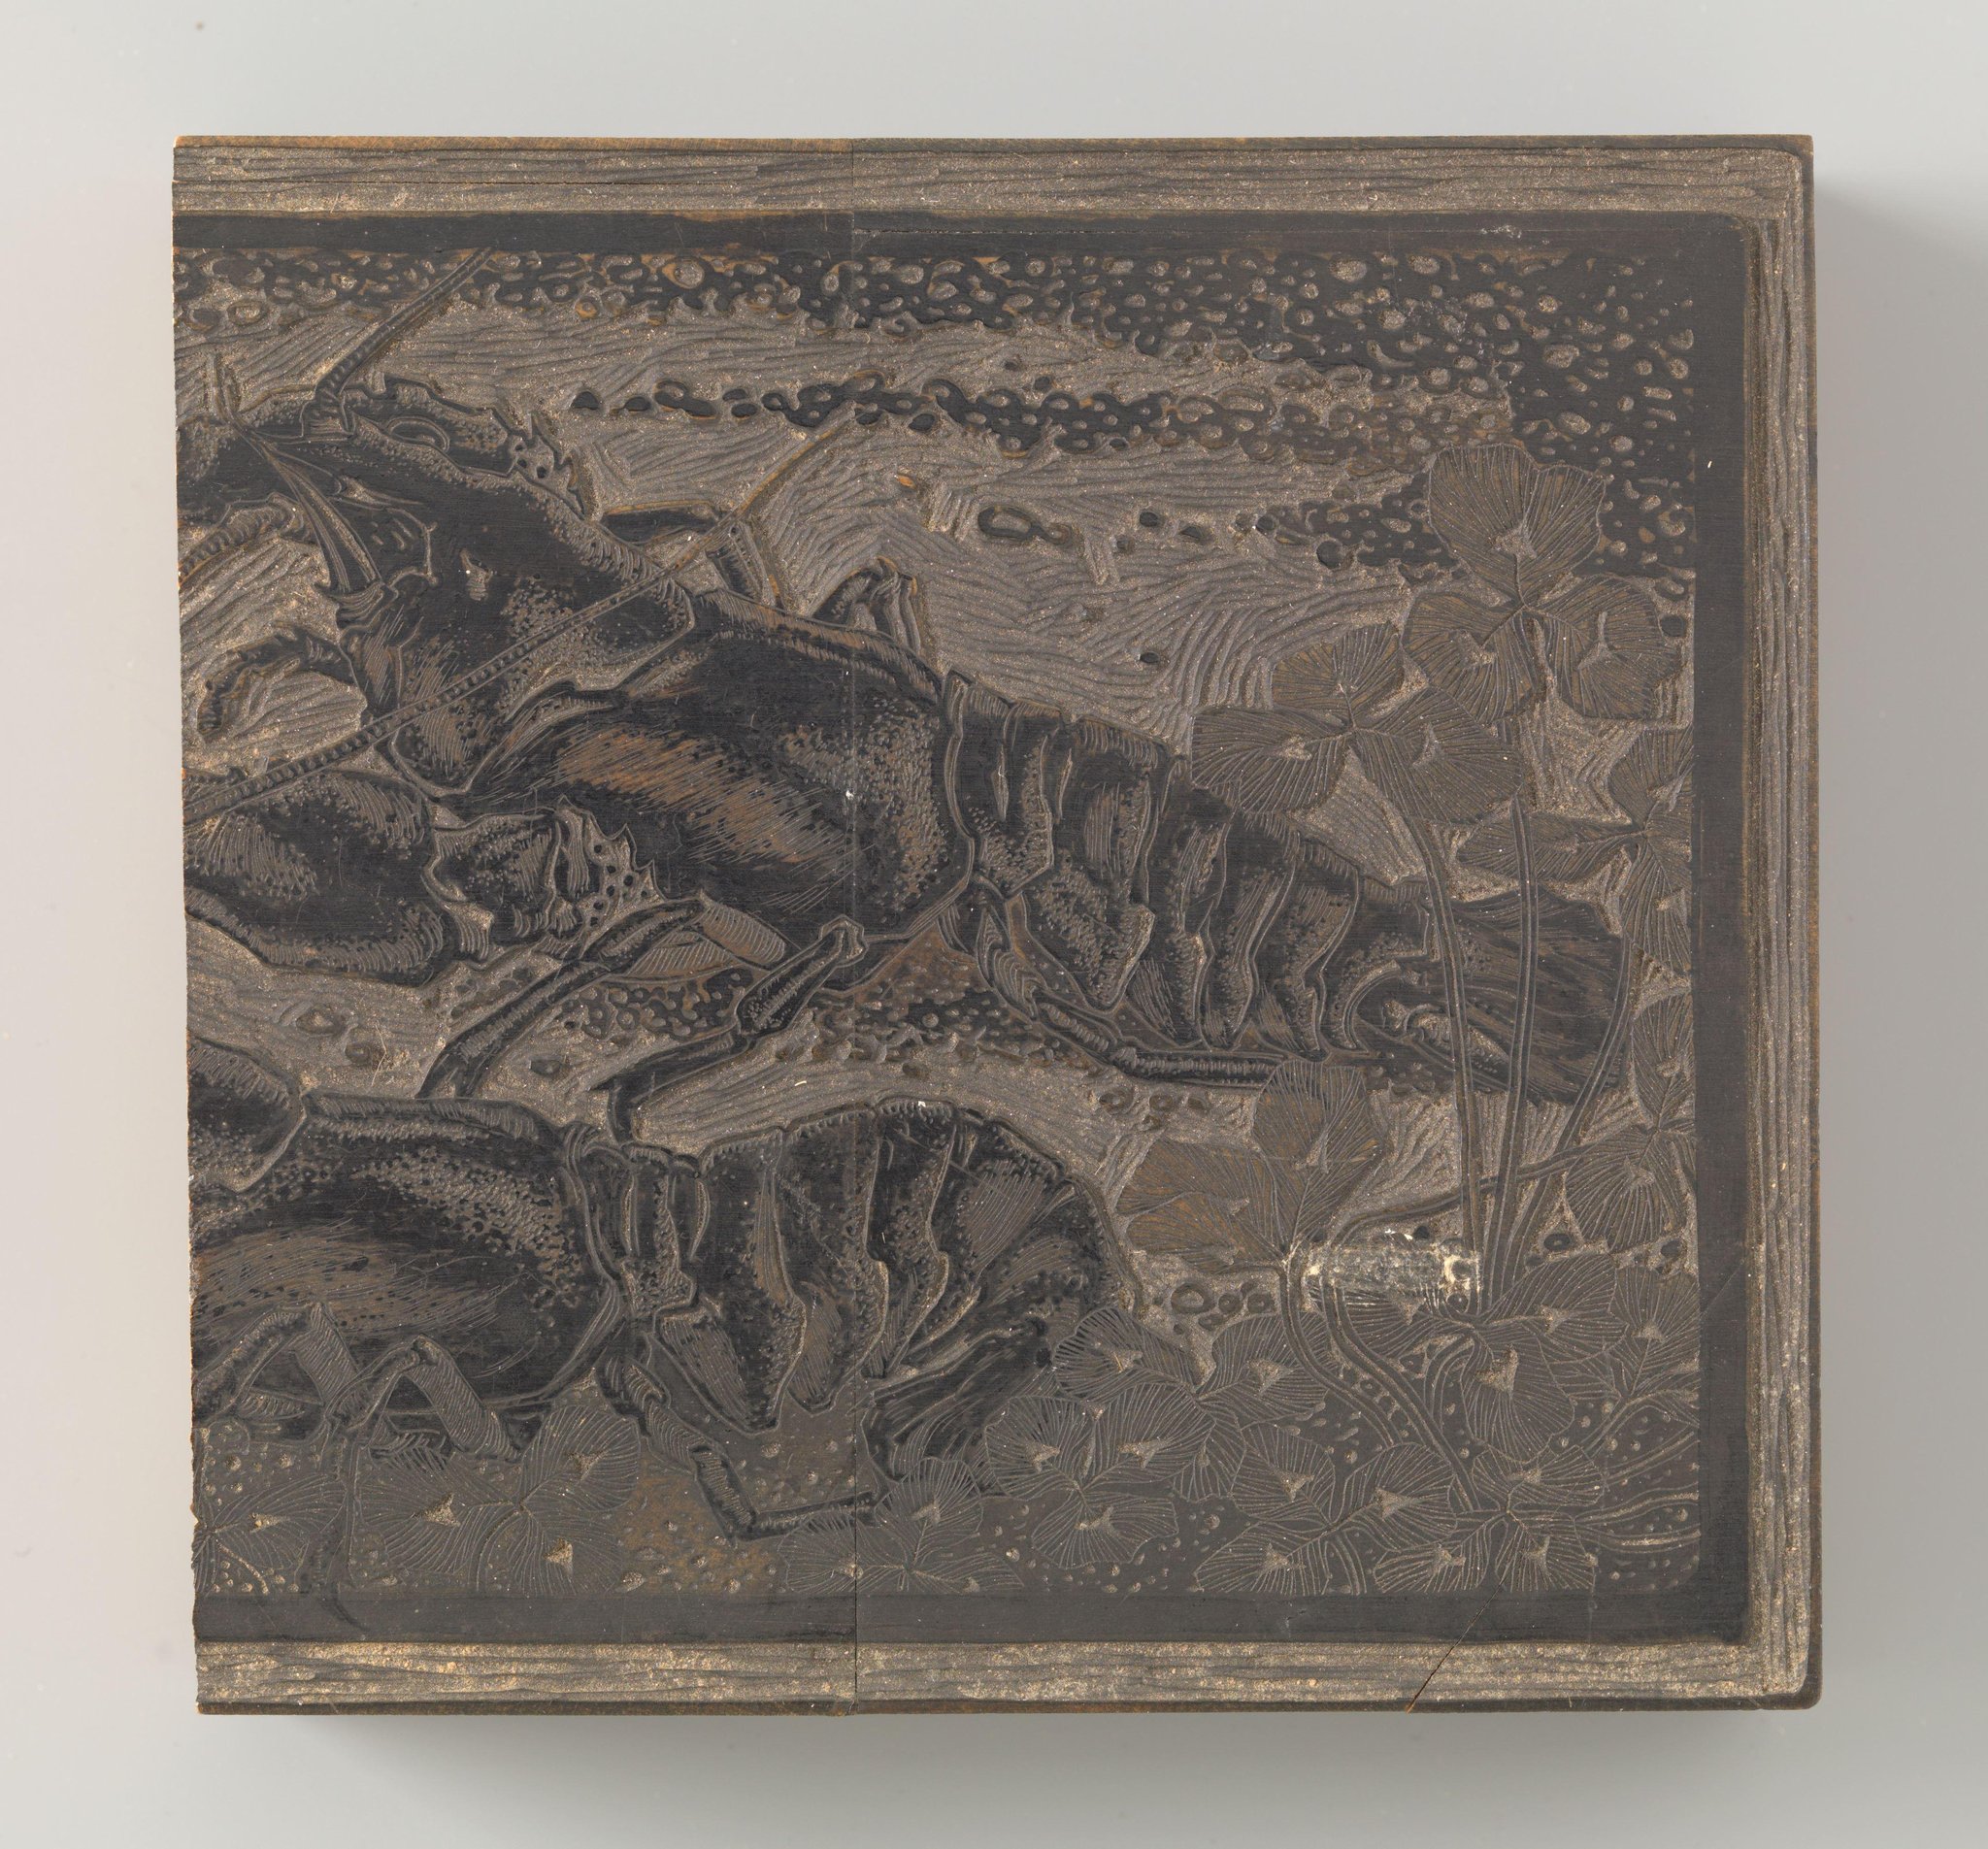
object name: houtblok kopshout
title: Twee kreeften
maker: julie de graag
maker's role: draughtsman, print maker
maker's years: 1877-1924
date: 1887-1924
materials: wood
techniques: woodcut